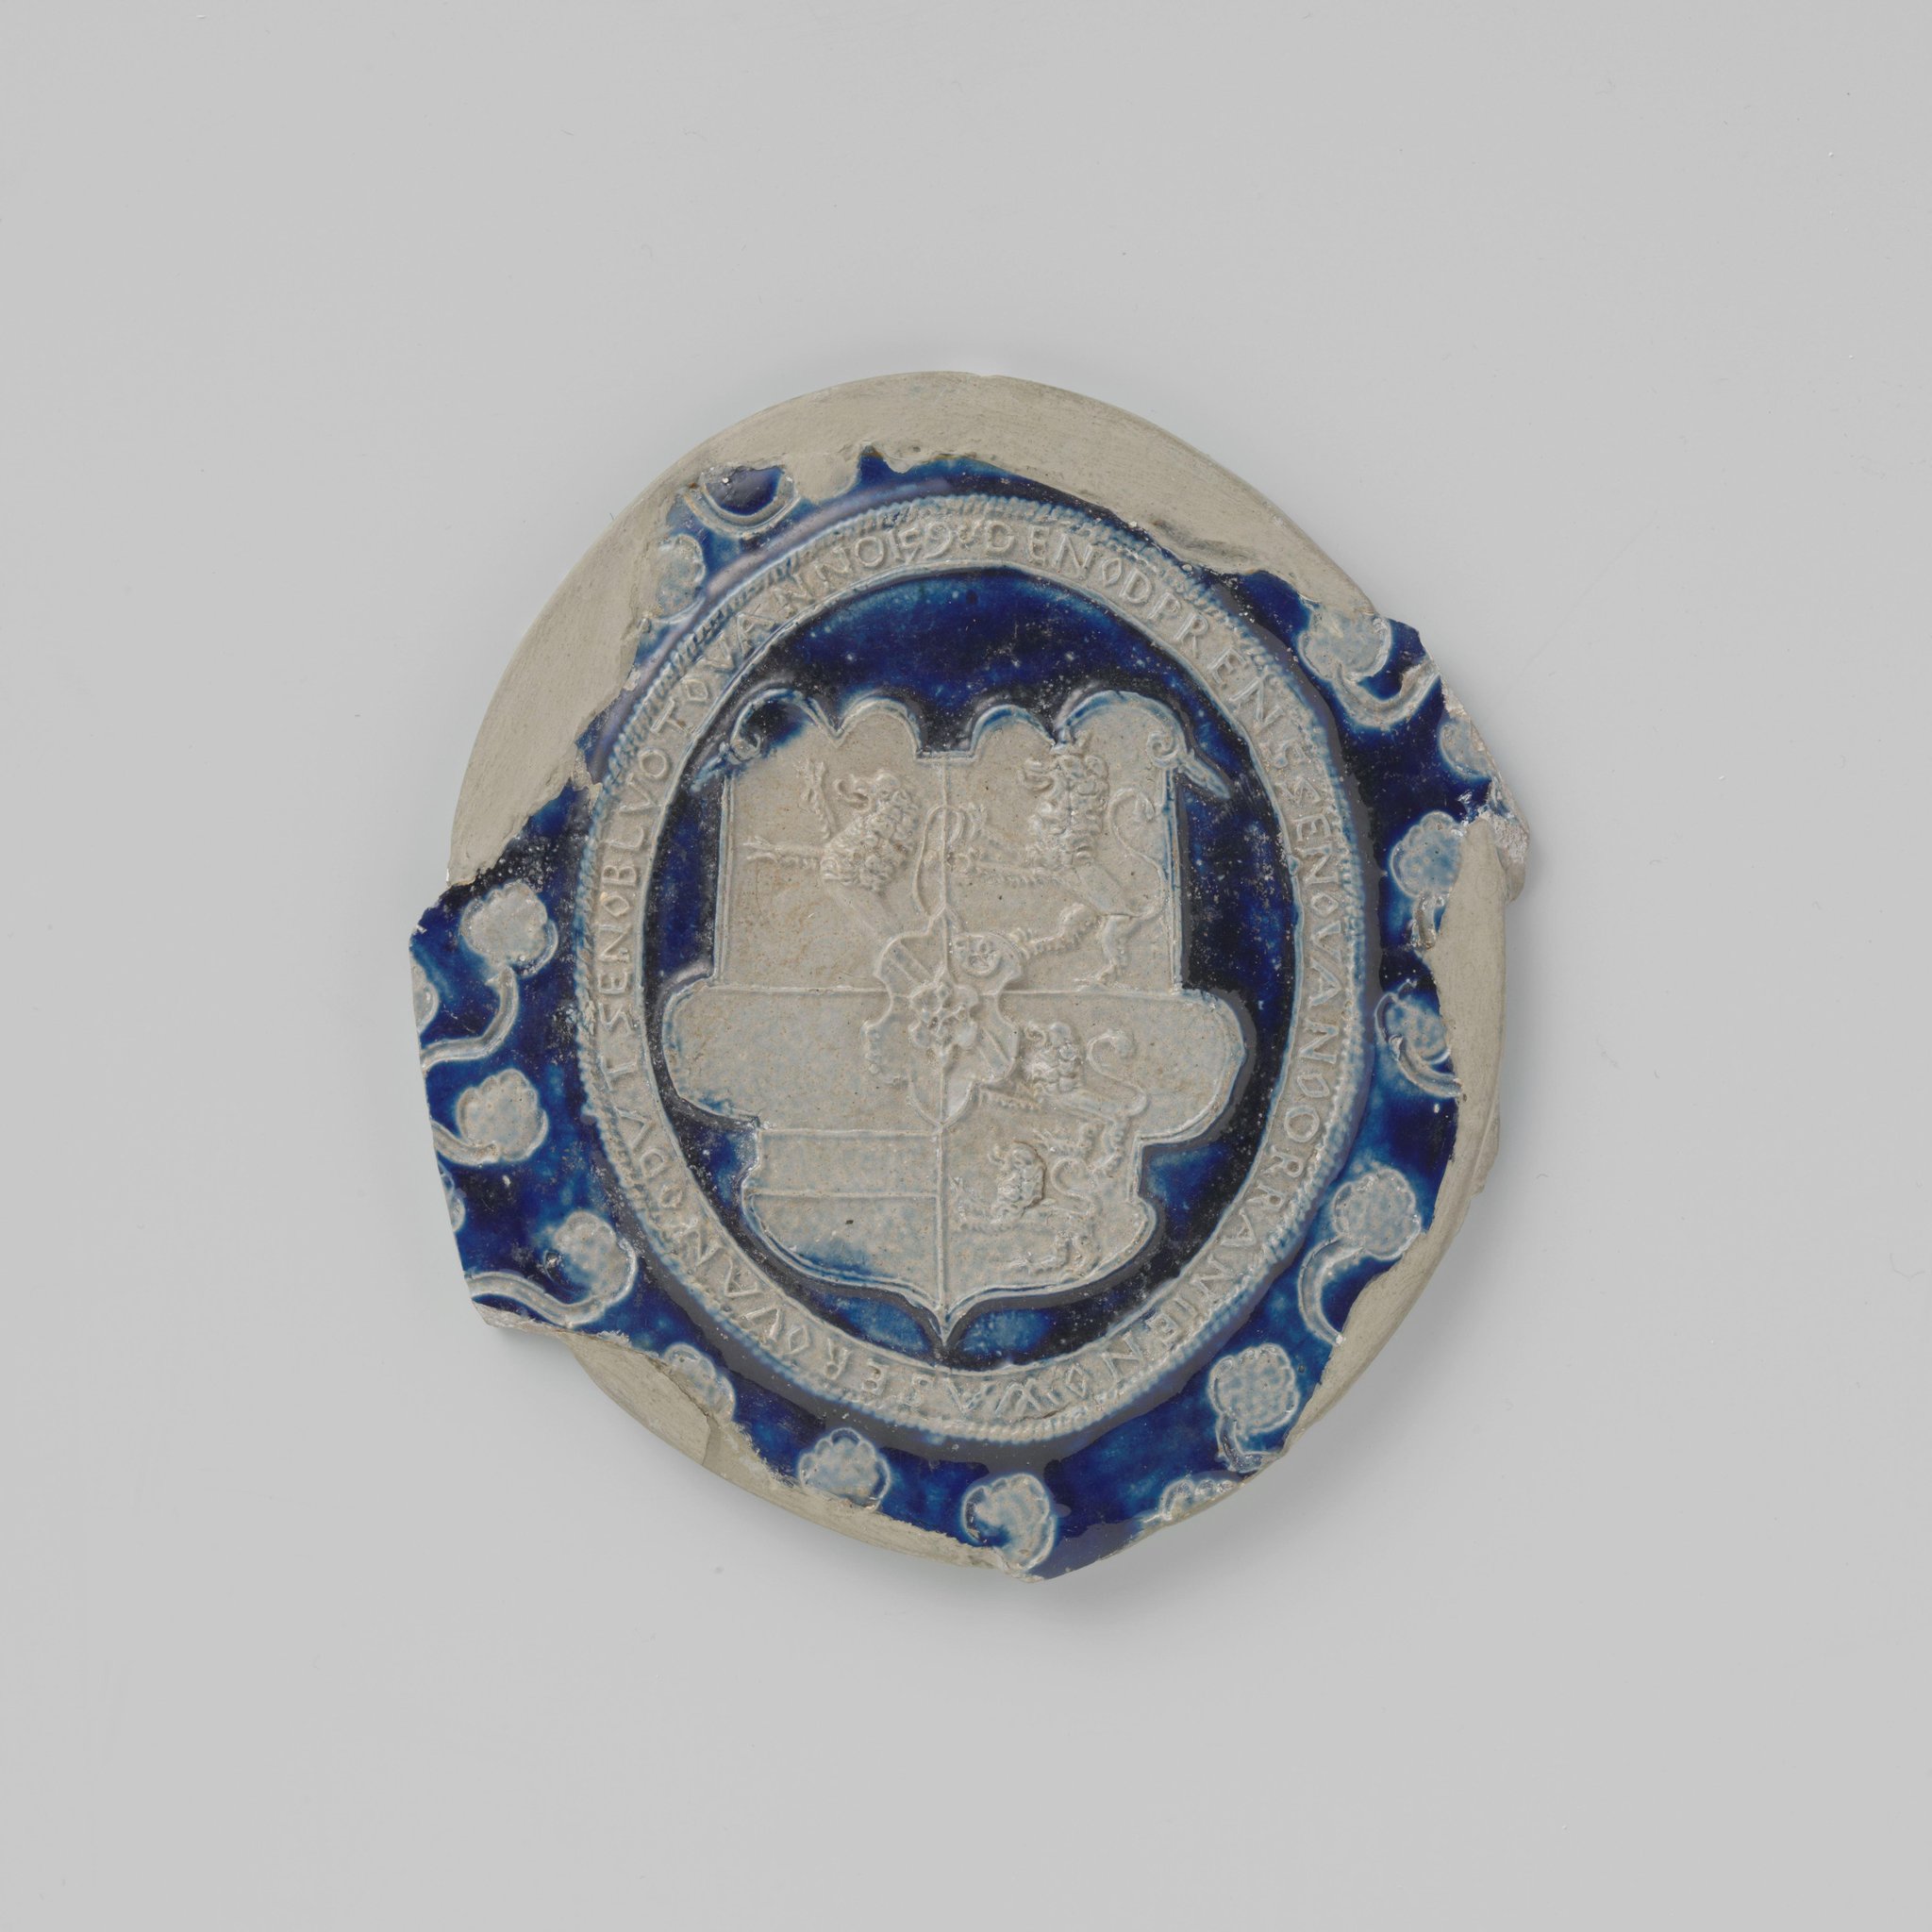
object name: sherd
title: Fragment with the coat of arms of William I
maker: Anonymous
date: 1590-1600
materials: cobalt, glaze, stoneware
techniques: printing, firing, relief, turning, vitrification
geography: raeren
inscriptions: inscription: ‘DEN DPRENSSEN VAN ORRANIEN WASER VAN DVTSEN BLVOT VANNO 1590’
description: Fragment van steengoed. Gedeeltelijk bedekt met kobaltblauw en door middel van aardewerk gevormd tot een medaillon. Op de scherf het wapen van Willem van Oranje met het randschrift 'DEN DPRENSSEN VAN ORRANIEN WASER VAN DVTSEN BLVOT VANNO 1590'. Om het medaillon ingegrifte ranken met gestempelde bloemen. Bijbehorende lijst BK-14712-2. Raeren.